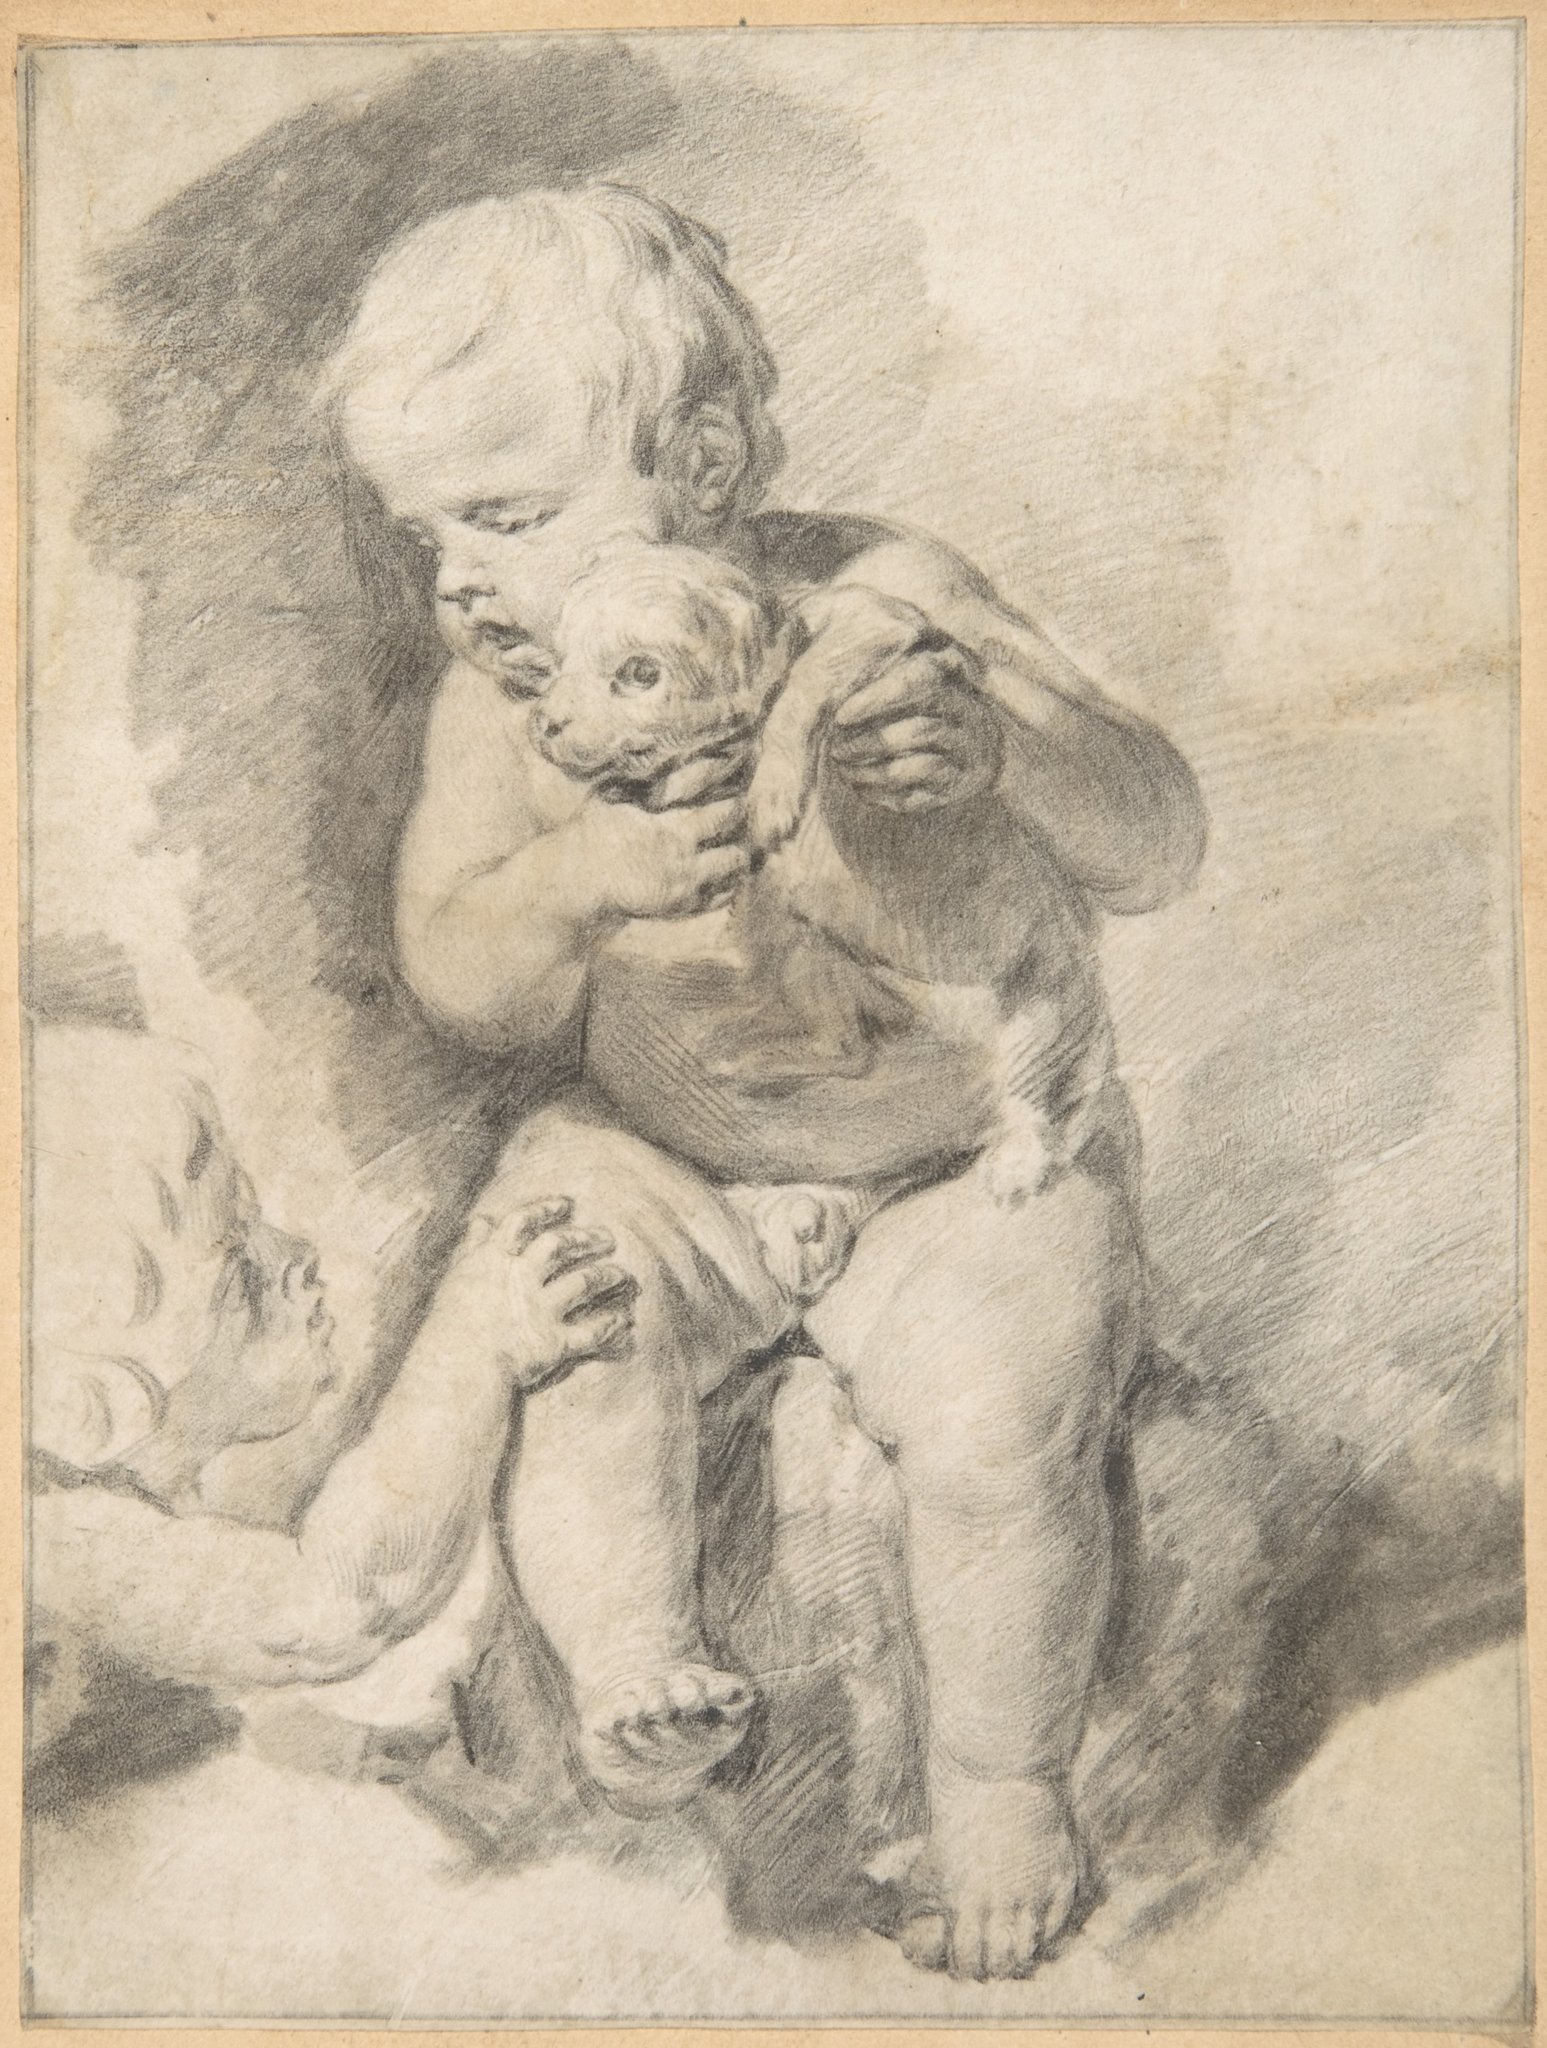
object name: drawing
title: Two Boys with a Puppy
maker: cornelis visscher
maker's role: artist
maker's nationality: dutch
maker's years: 1628-1658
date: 1656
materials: chalk, graphite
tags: boys,dogs